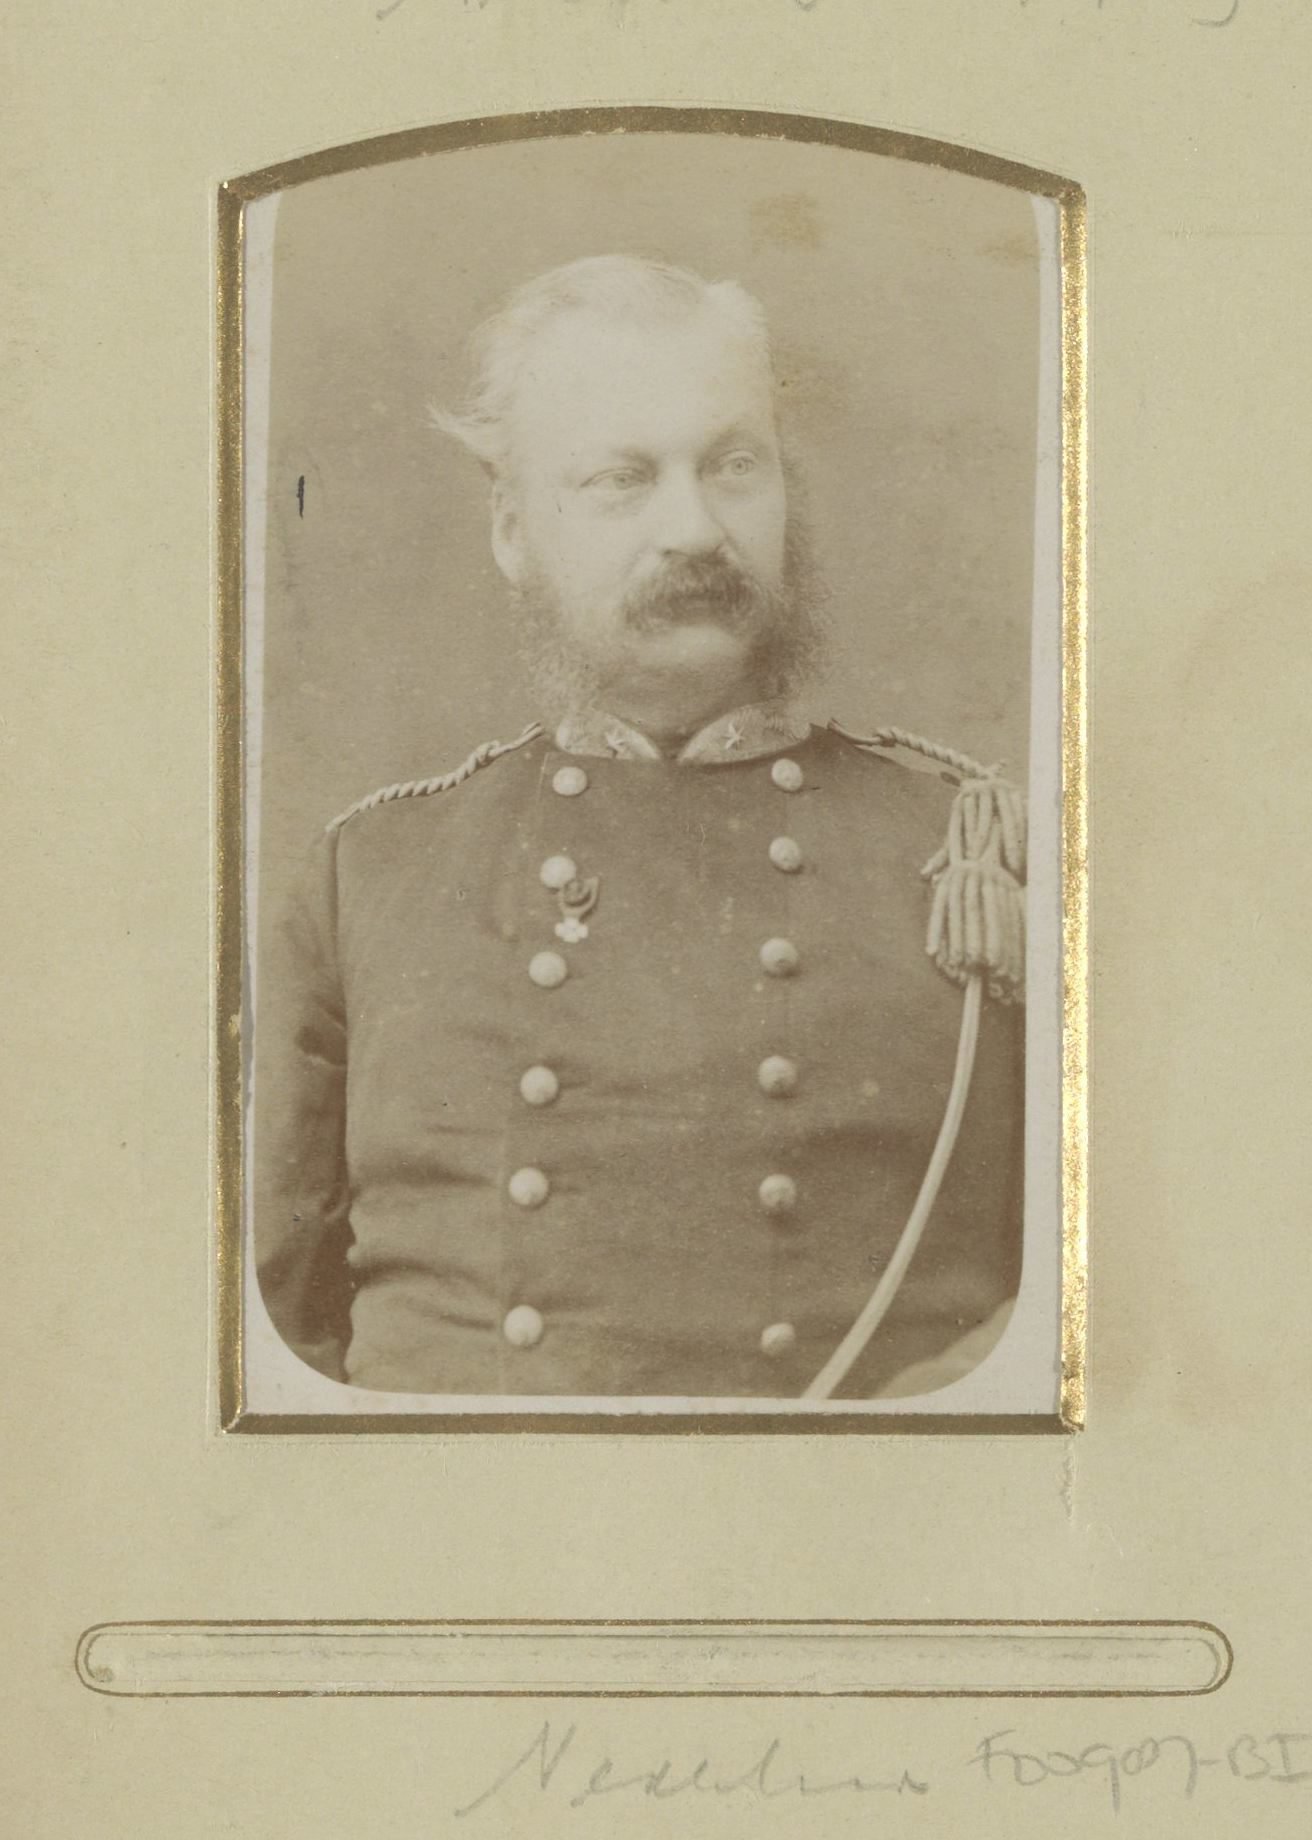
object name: photograph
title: Portret van een (vermoedelijk) Nederlandse militair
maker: carel gustaaf hisgen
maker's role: fotograaf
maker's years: 1852-1917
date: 1884-1897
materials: cardboard, paper, photographic support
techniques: albumen print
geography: utrecht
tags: sideburns, warfare; military affairs, (military) uniforms, division of armed forces, utrecht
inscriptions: address: ‘Leidsche Weg, L.8 Utrecht’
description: Onderdeel van Album met cartes-de-visite en kabinetfoto's van militairen in uniform.